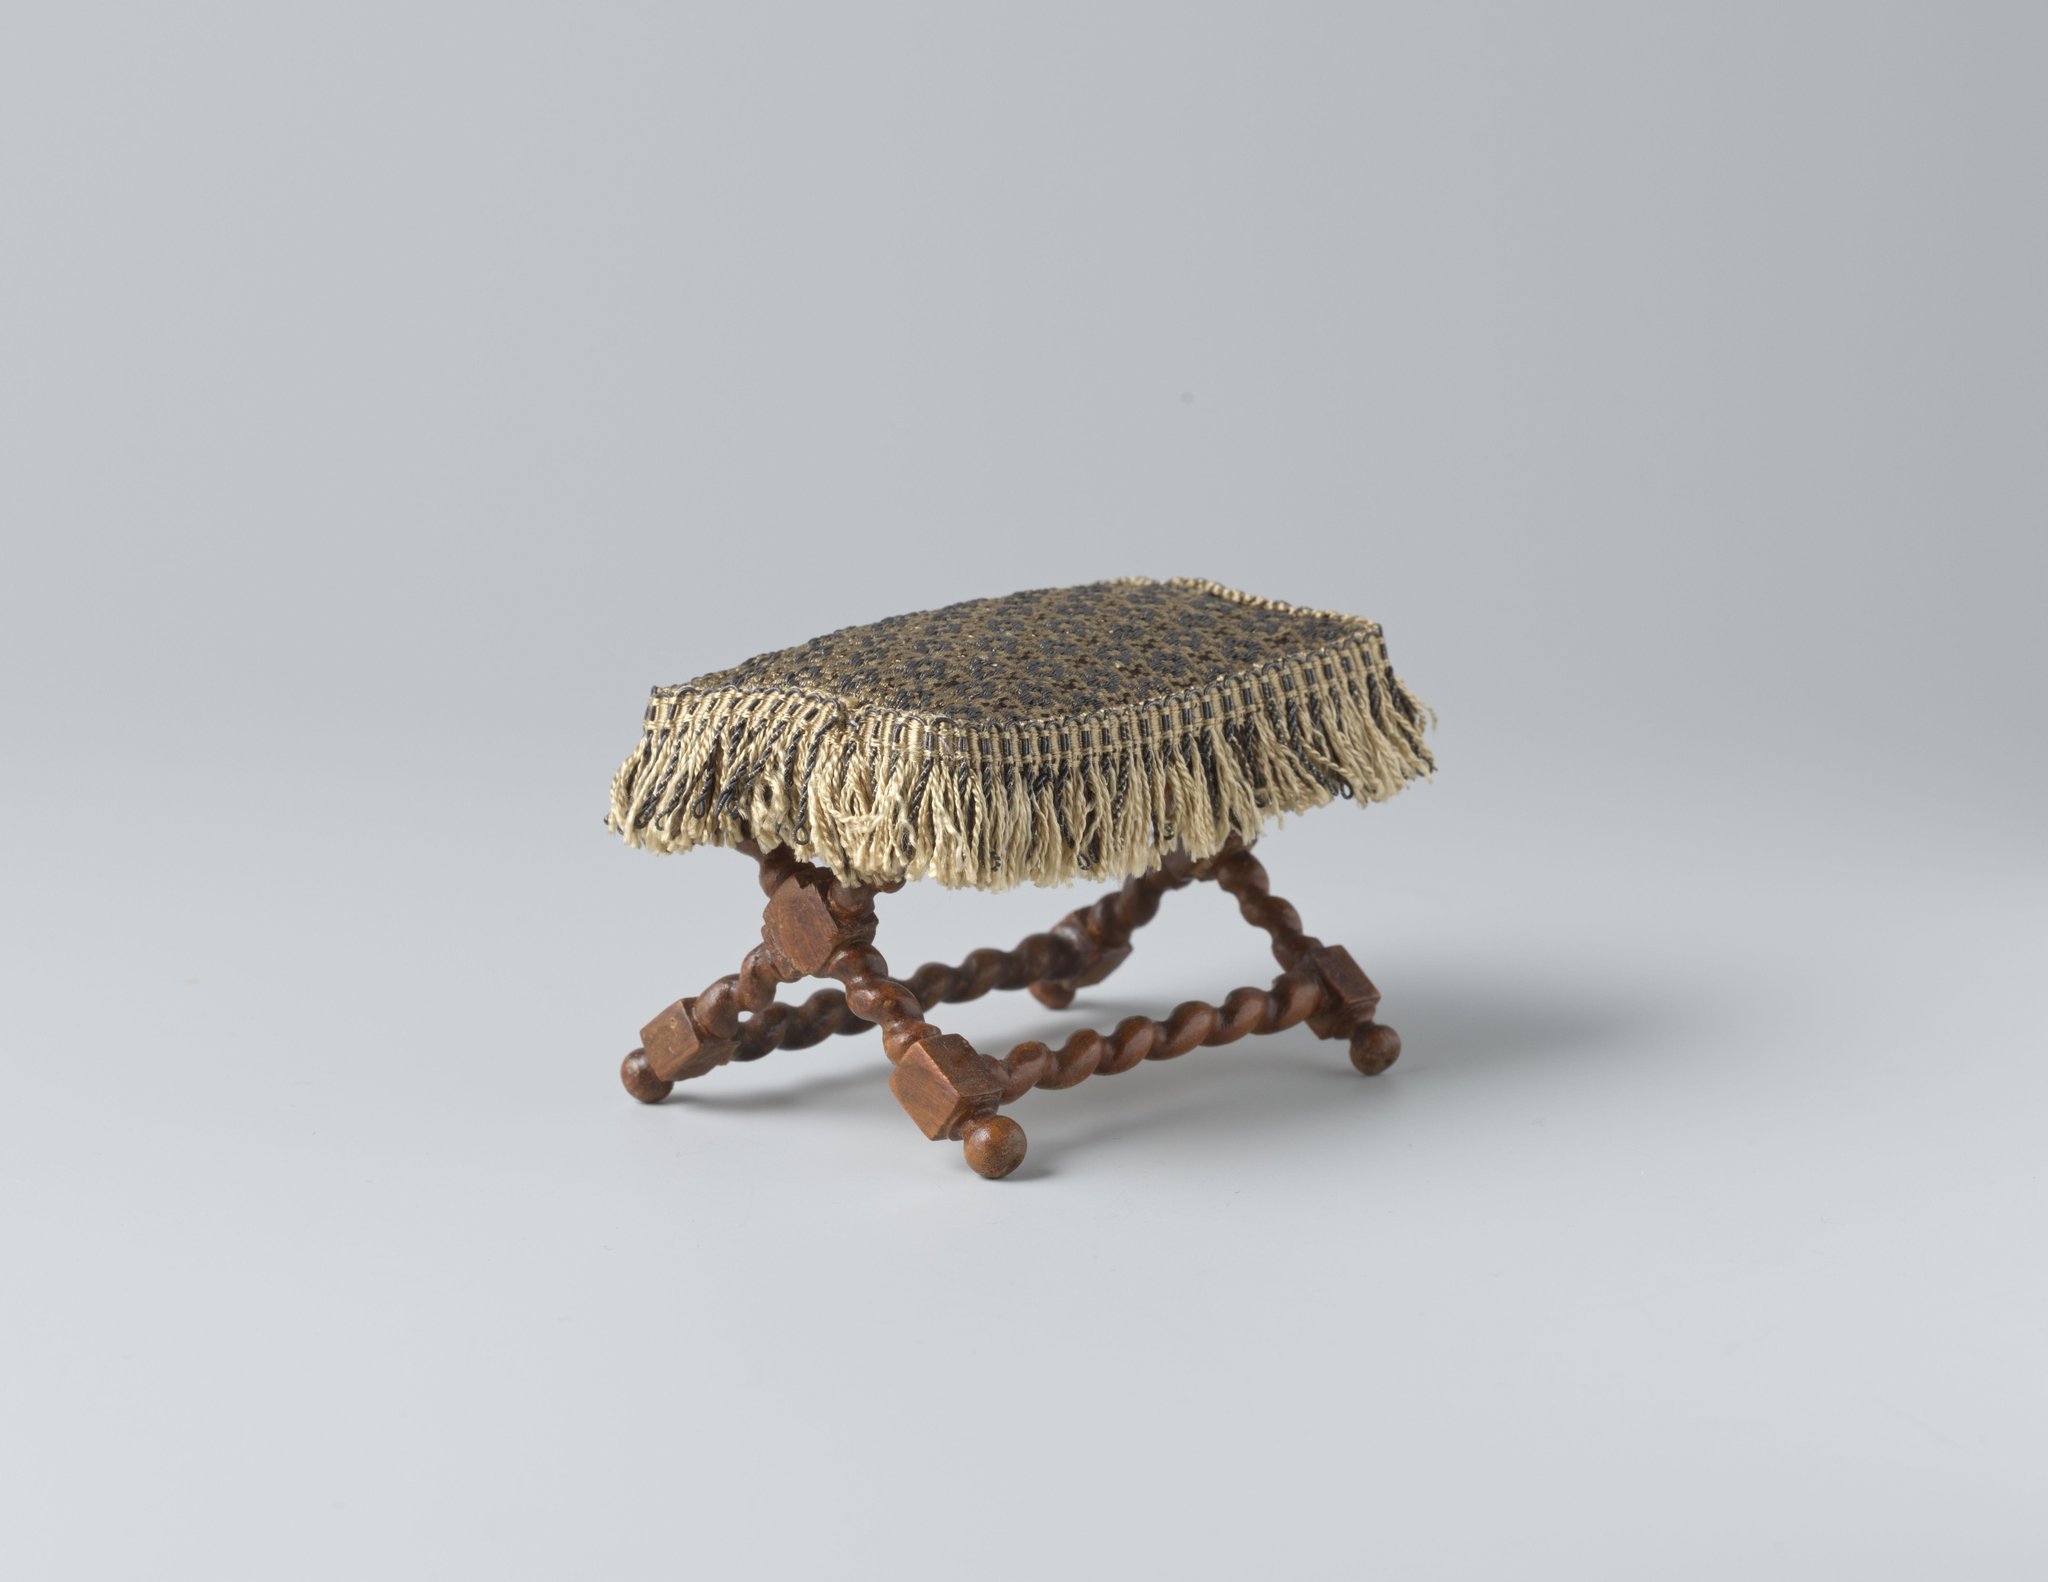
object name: tabouret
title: Taboeret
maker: Anonymous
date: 1676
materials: linen, wood, silk, thread, wool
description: Taboeret met rechthoekige zitting, op getorste poten van olijfhout, de poten zijn twee aan twee gekruist en worden verbonden aan de onderzijde door twee getorste dwarspoten, en boven door twee gladde dwarsregels. Tussen de bovenregels is de zitting gespannen, bestaande uit een linnen onderlaag, waarop wolpluis, afgedekt door een complex weefsel van zijde en metaaldraad met geometrisch patroon in de kleuren geel en zwart. De stof is rondom afgezet met passement met franje van dezelfde gele en zwarte zijde en verguld zilverdraad.